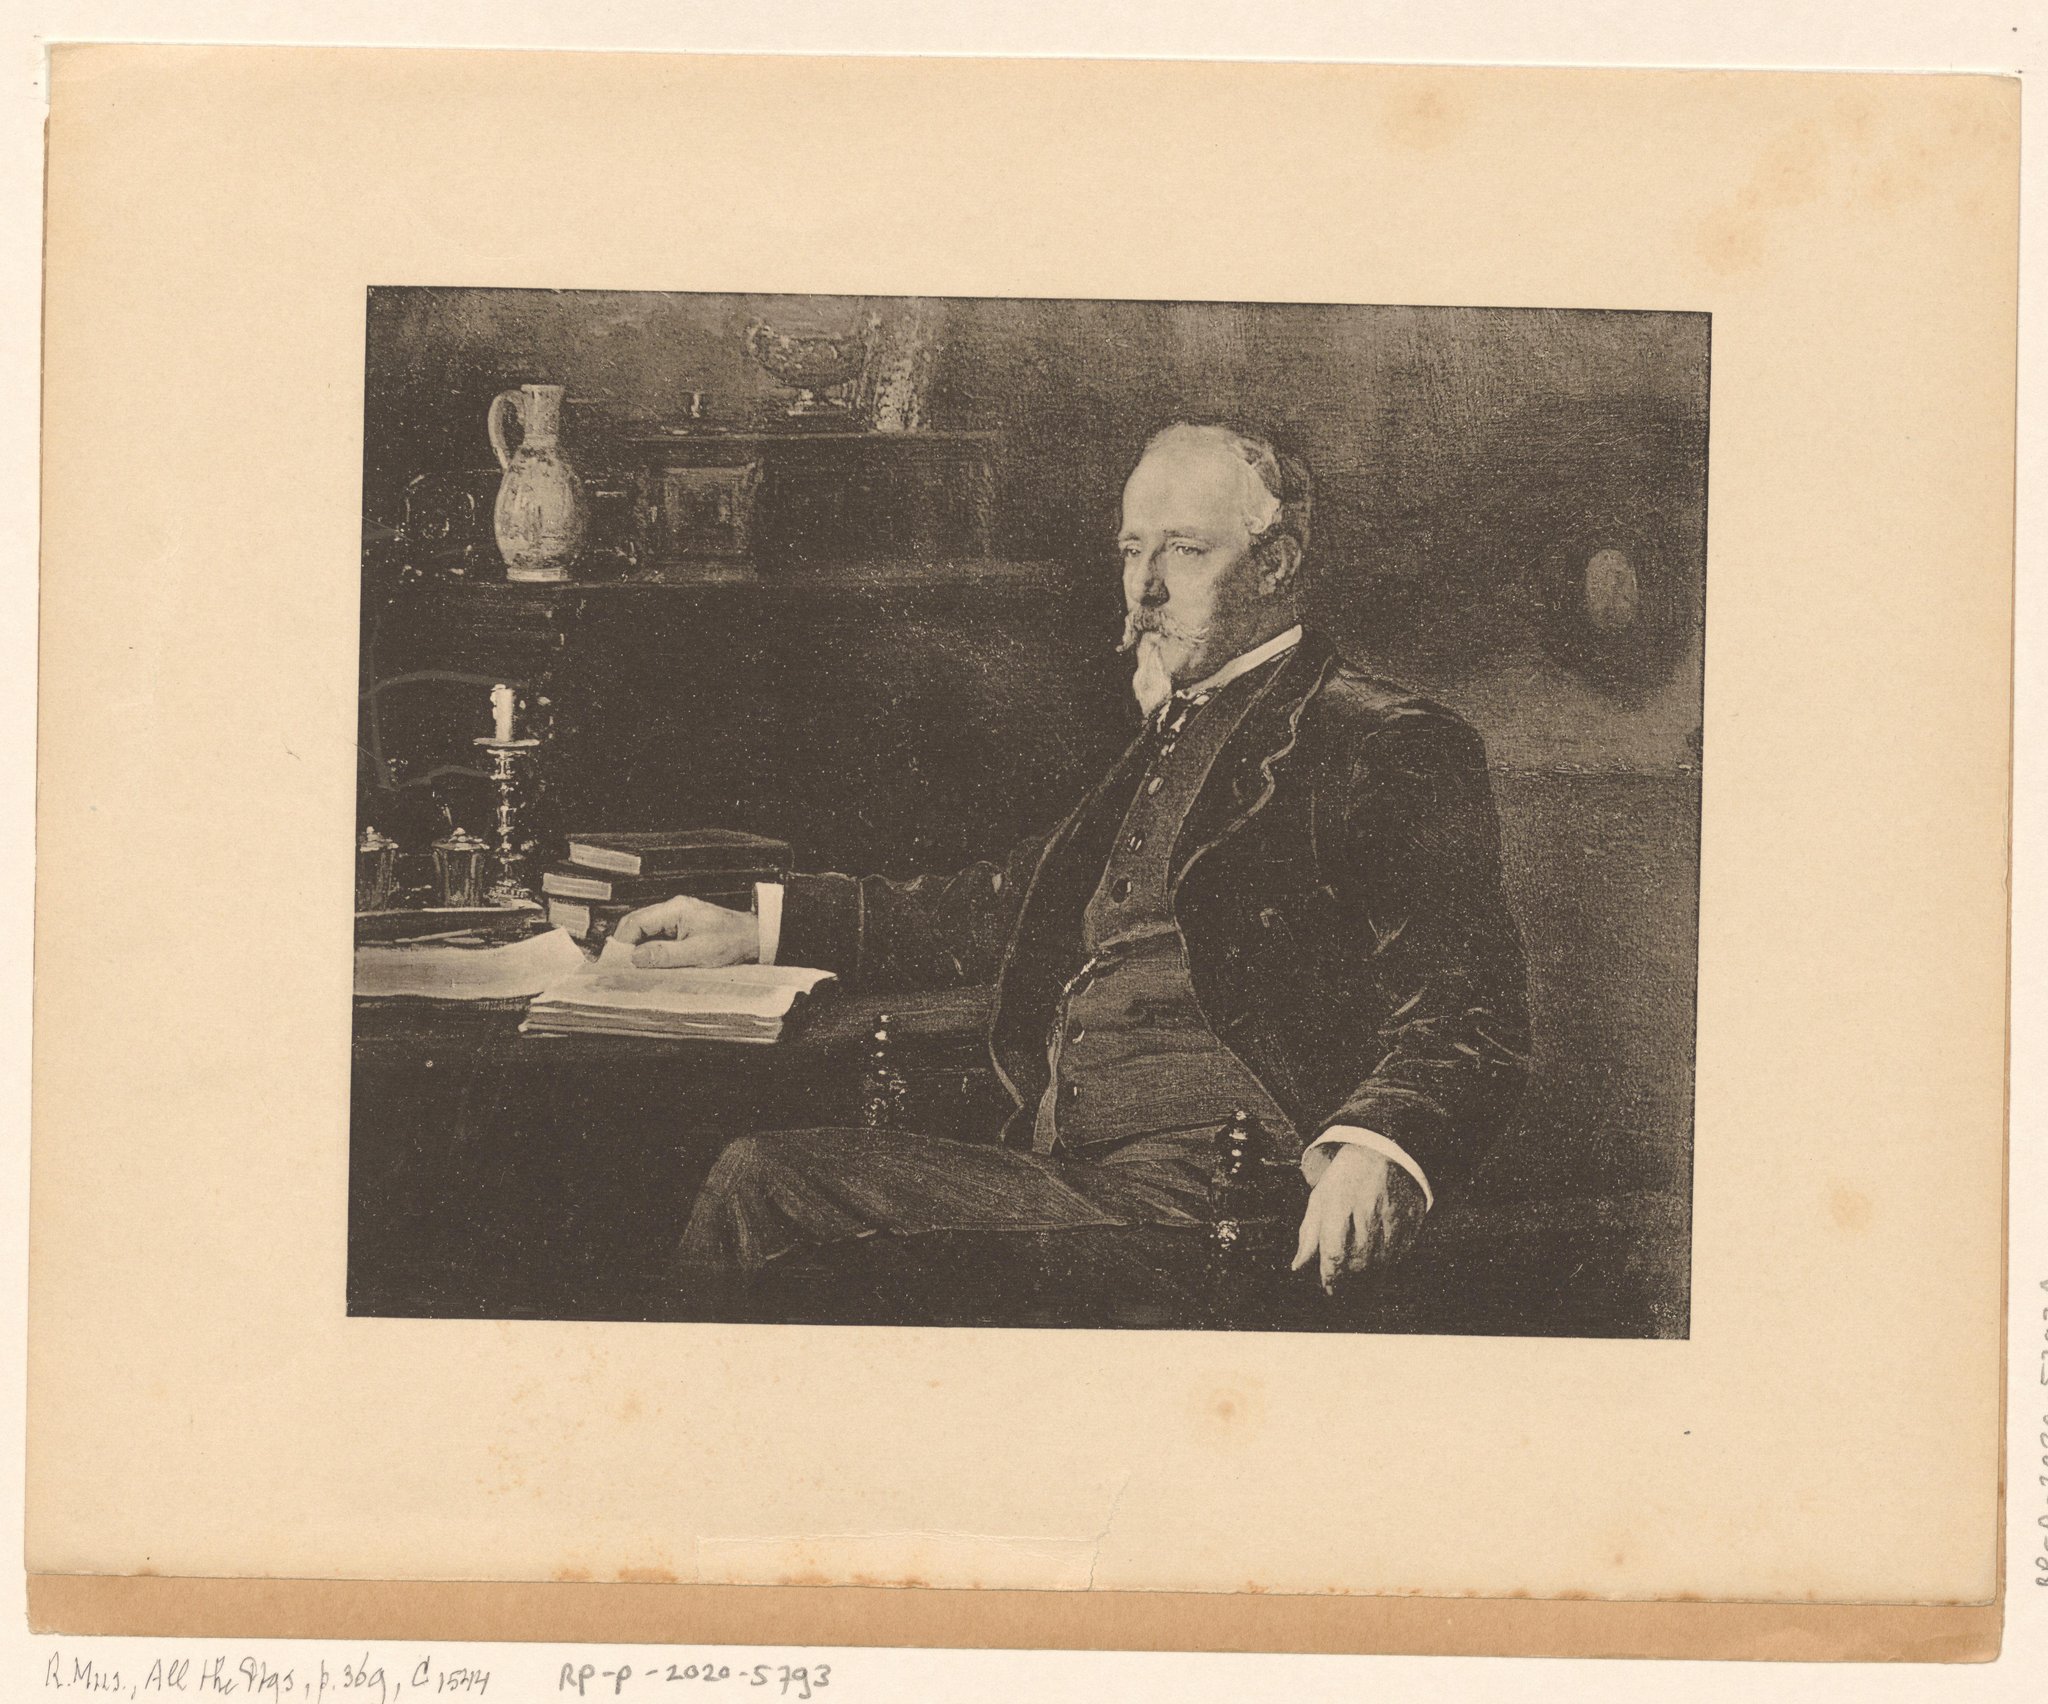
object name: photomechanical print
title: Portret van Daniël Franken Dzn.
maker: Anonymous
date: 1899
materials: paper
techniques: photograph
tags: daniël franken dzn., historical persons, art collector, book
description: Prent komt uit de bijlage van het 41e jaarverslag van het Koninklijk Oudheidkundig Genootschap, 1899. Bij de prent zitten twee pagina's tekst uit dit jaarverslag met een biografie van Franken.